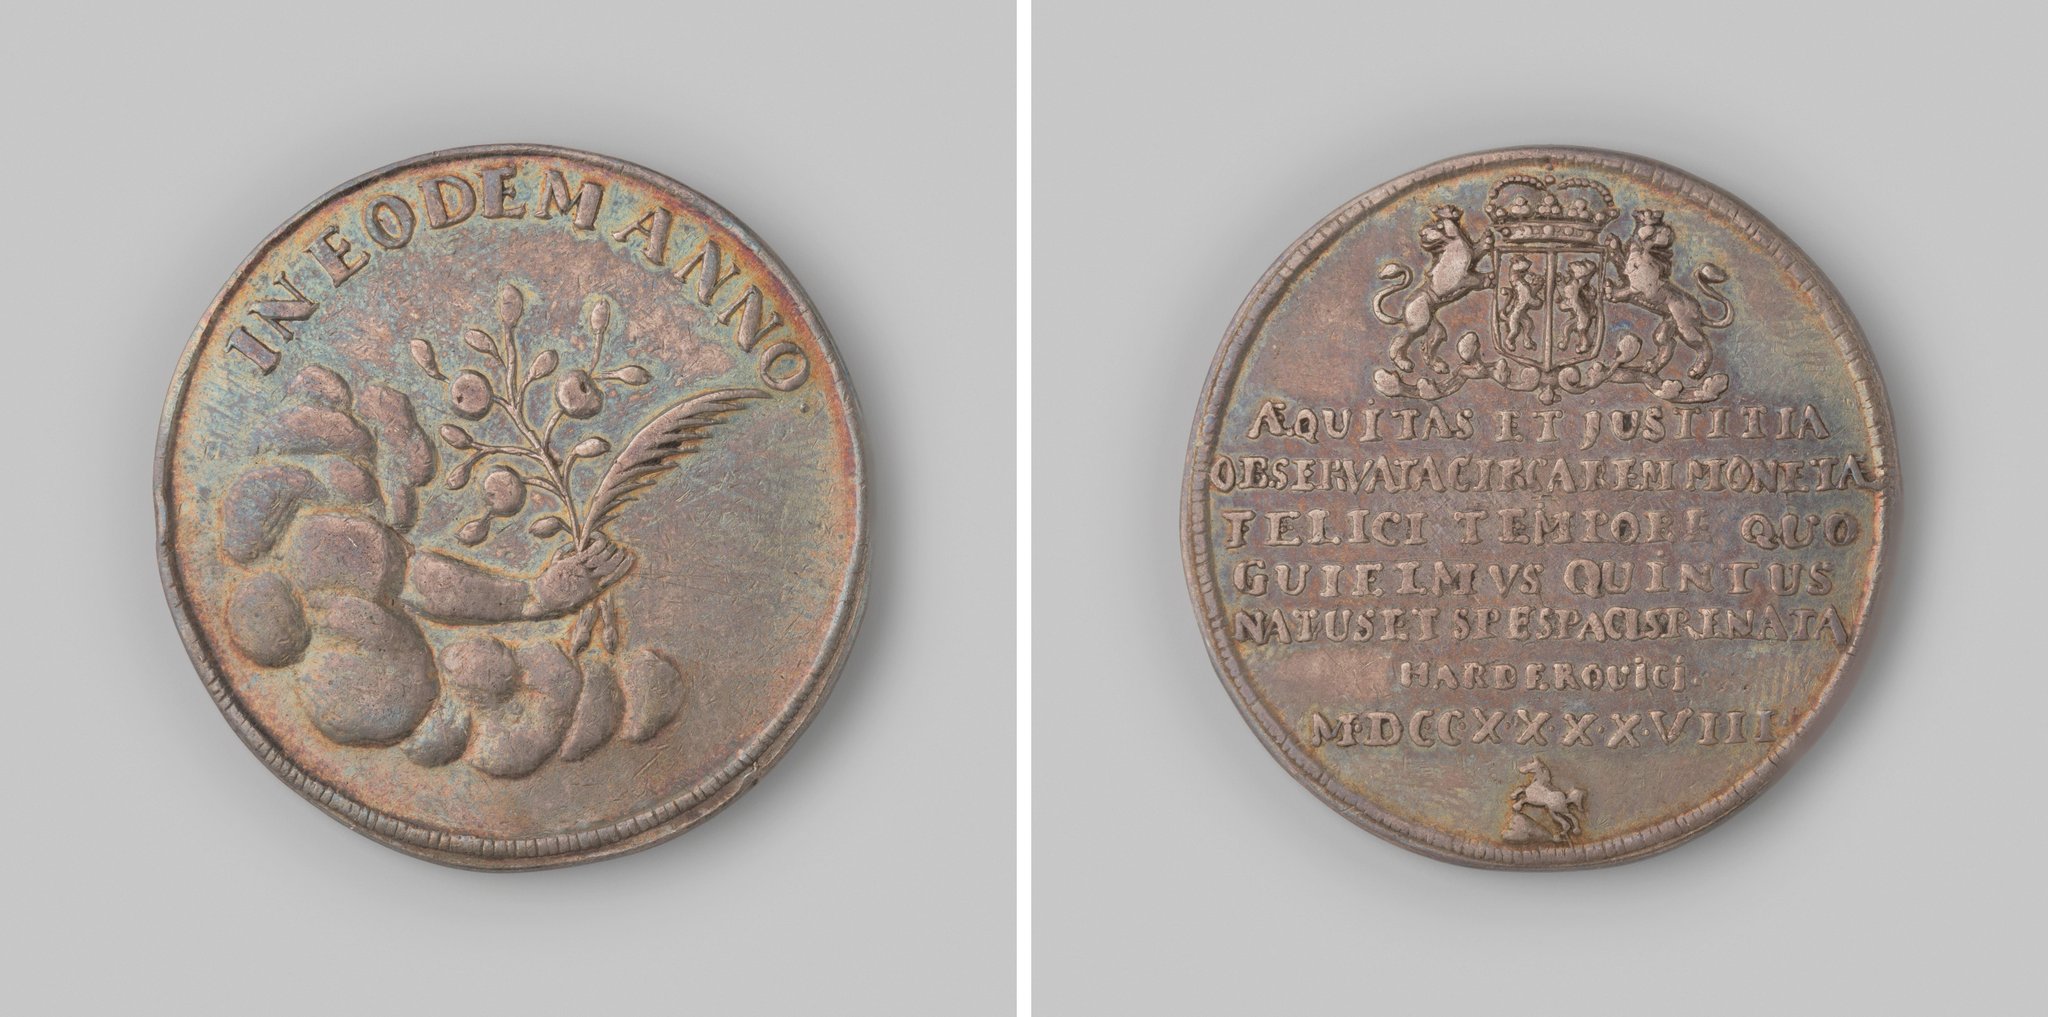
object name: history medal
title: Nazien van de Gelderse munt en de geboorte van Willem V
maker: jan bernard barghuys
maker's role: die cutter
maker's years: 1684-1760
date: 1748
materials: silver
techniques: striking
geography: harderwijk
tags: the hague, william v (prince of orange)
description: Zilveren penning. Voorzijde: hand uit wolken met oranje- en olijftak binnen omschrift. Keerzijde: opschrift onder gekroond wapenschild; muntteken: steigerend paard.